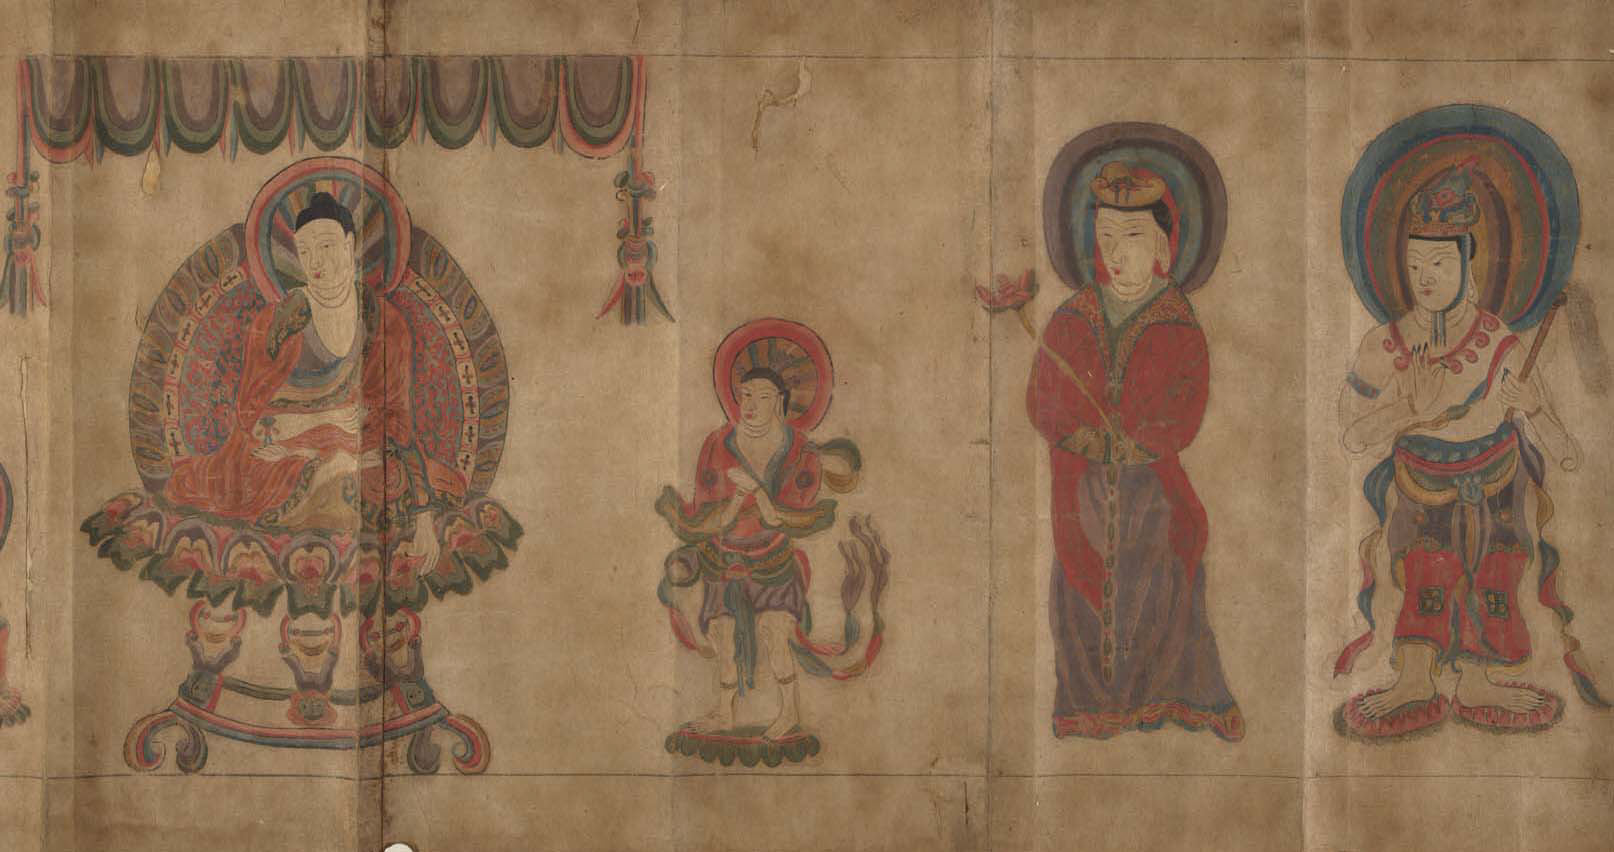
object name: handscroll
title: Part of a Buddhistic Sutra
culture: chinese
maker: unidentified artist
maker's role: artist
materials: ink, paper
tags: human figures,buddhism,buddha